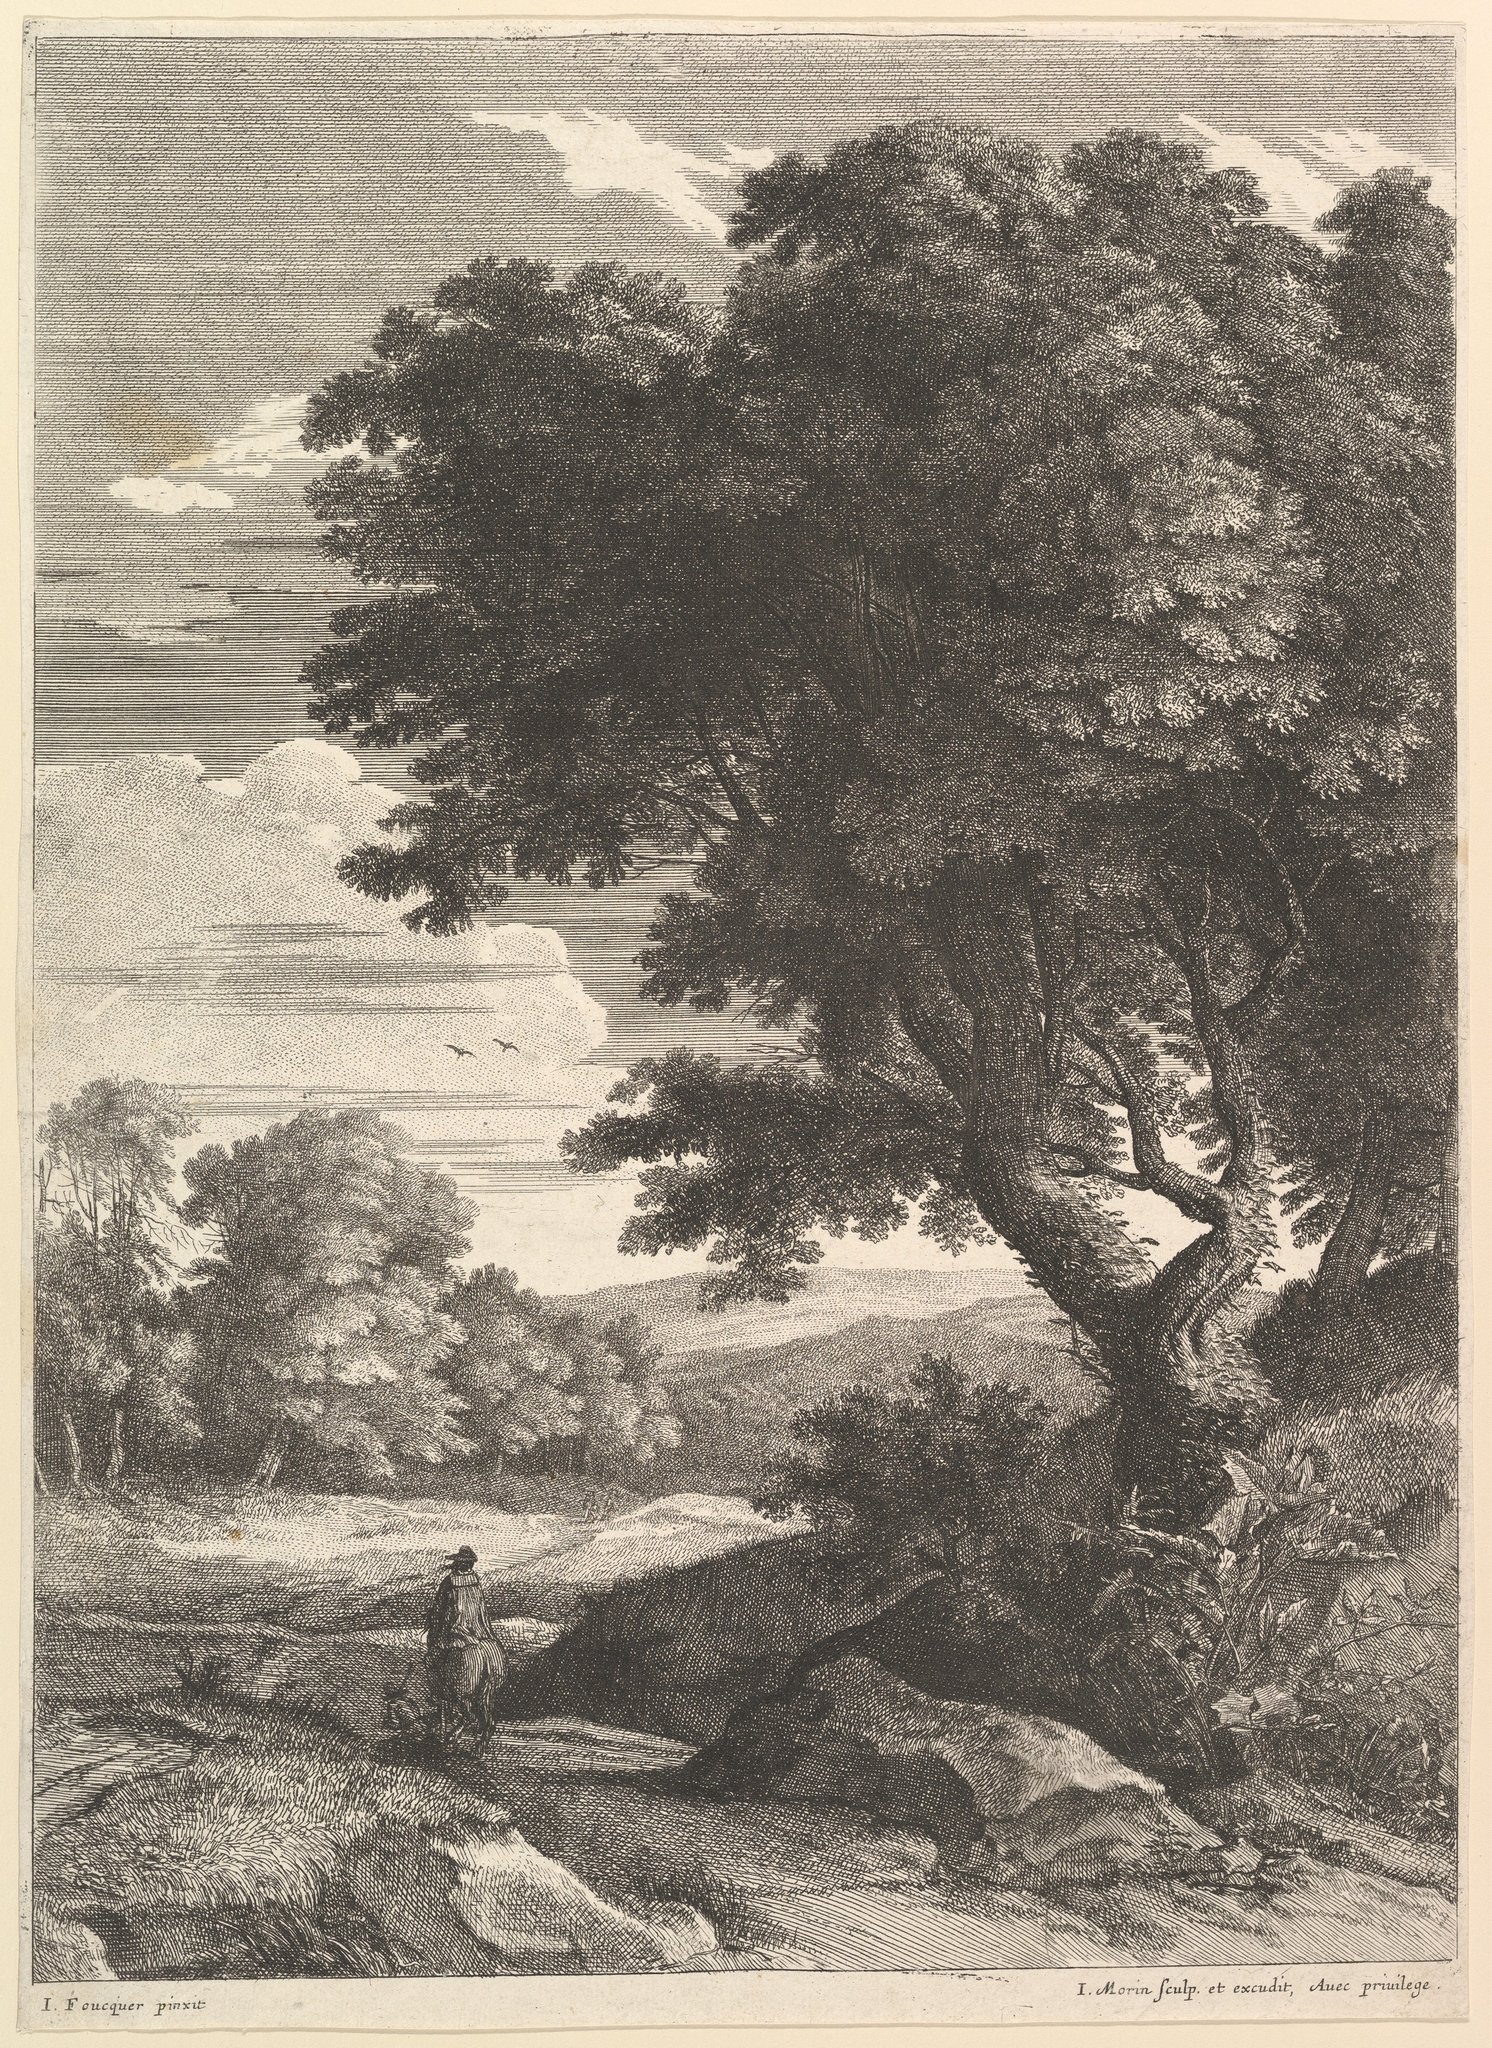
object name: print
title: Le Cavalier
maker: jean morin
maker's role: artist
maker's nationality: french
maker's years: 1605-1650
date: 1605-1650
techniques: etching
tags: landscapes,trees